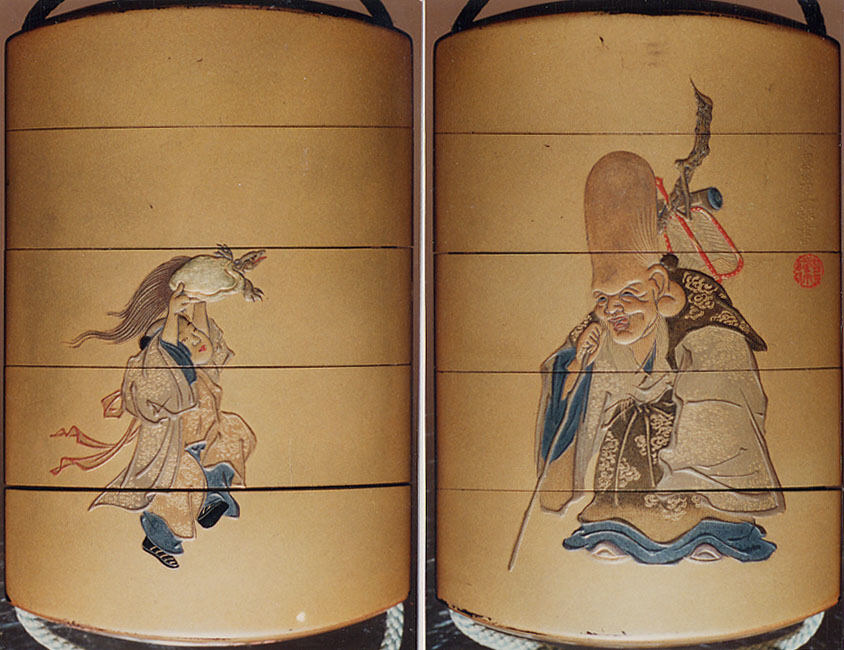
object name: inrō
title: Case (Inrō) with Design of Deity of Longevity (Jurōjin) (obverse); Boy Offering a Tortoise (reverse)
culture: japanese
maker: tachibana gyokuzan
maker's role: artist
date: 1801-1900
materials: foil, gold, lacquer, metal, wood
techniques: hiramakie, lacquer, polish, relief, maki-e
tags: boys,men,turtles,deities